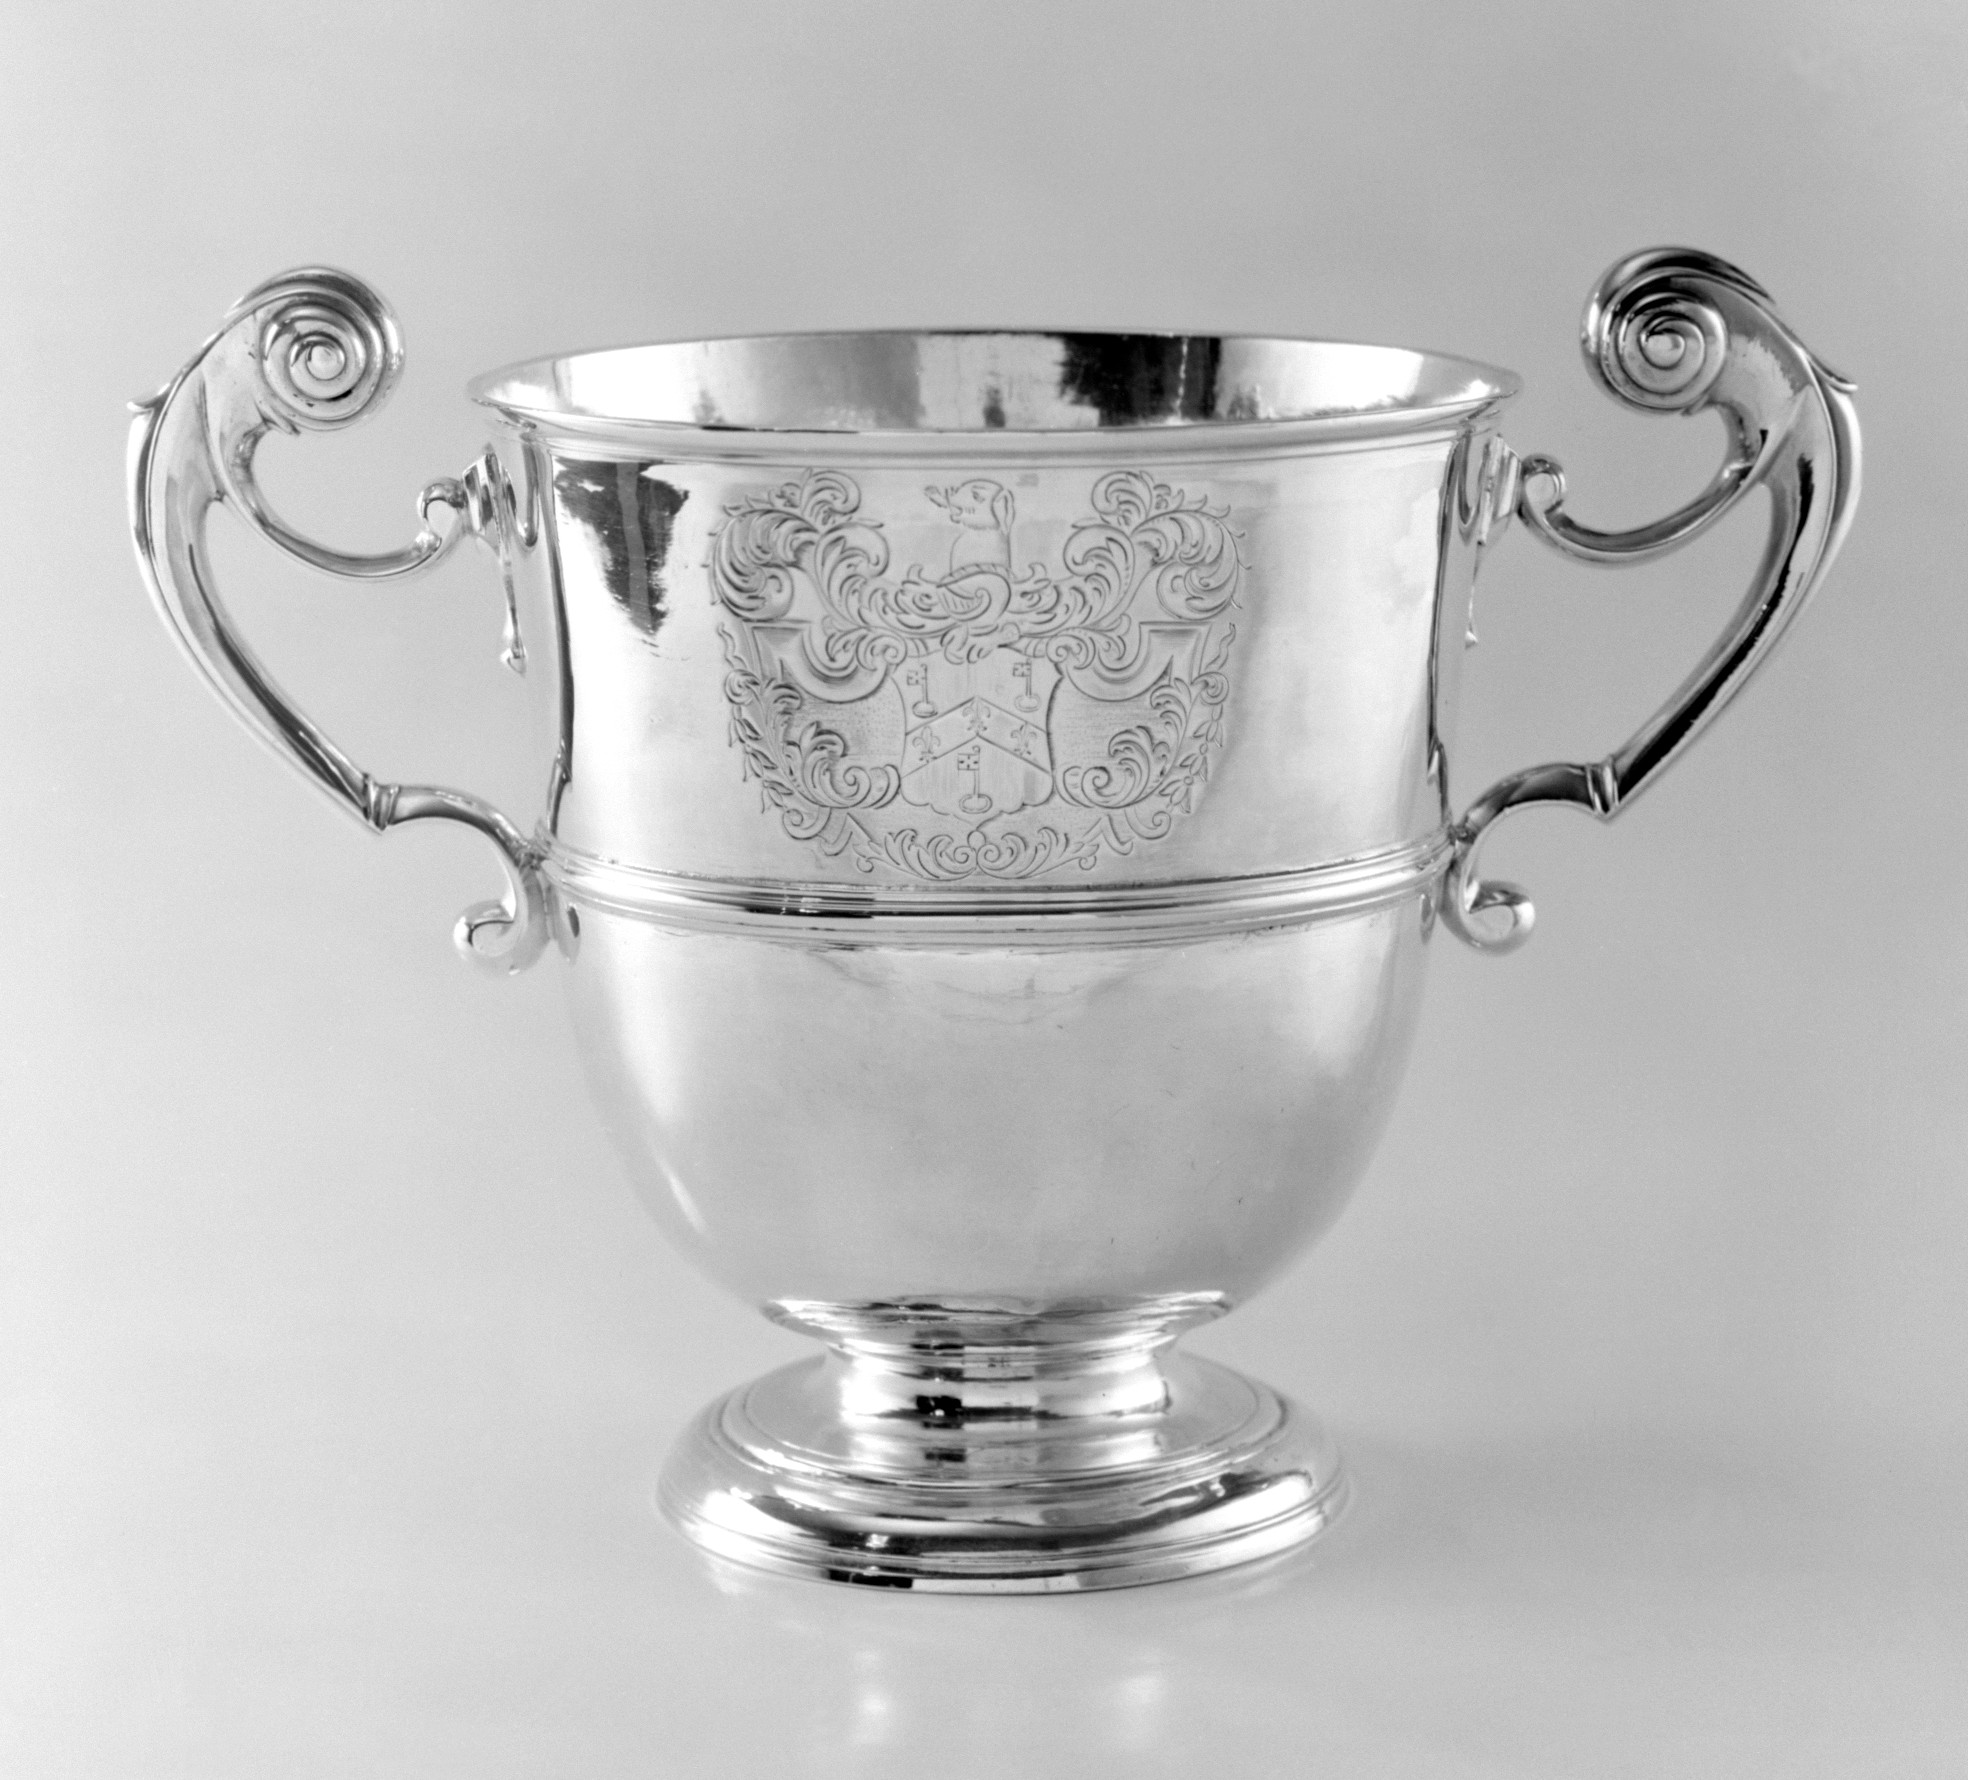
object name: cup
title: Two-handled cup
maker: christopher locker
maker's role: maker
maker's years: 1675-1775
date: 1728-1729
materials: silver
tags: coat of arms